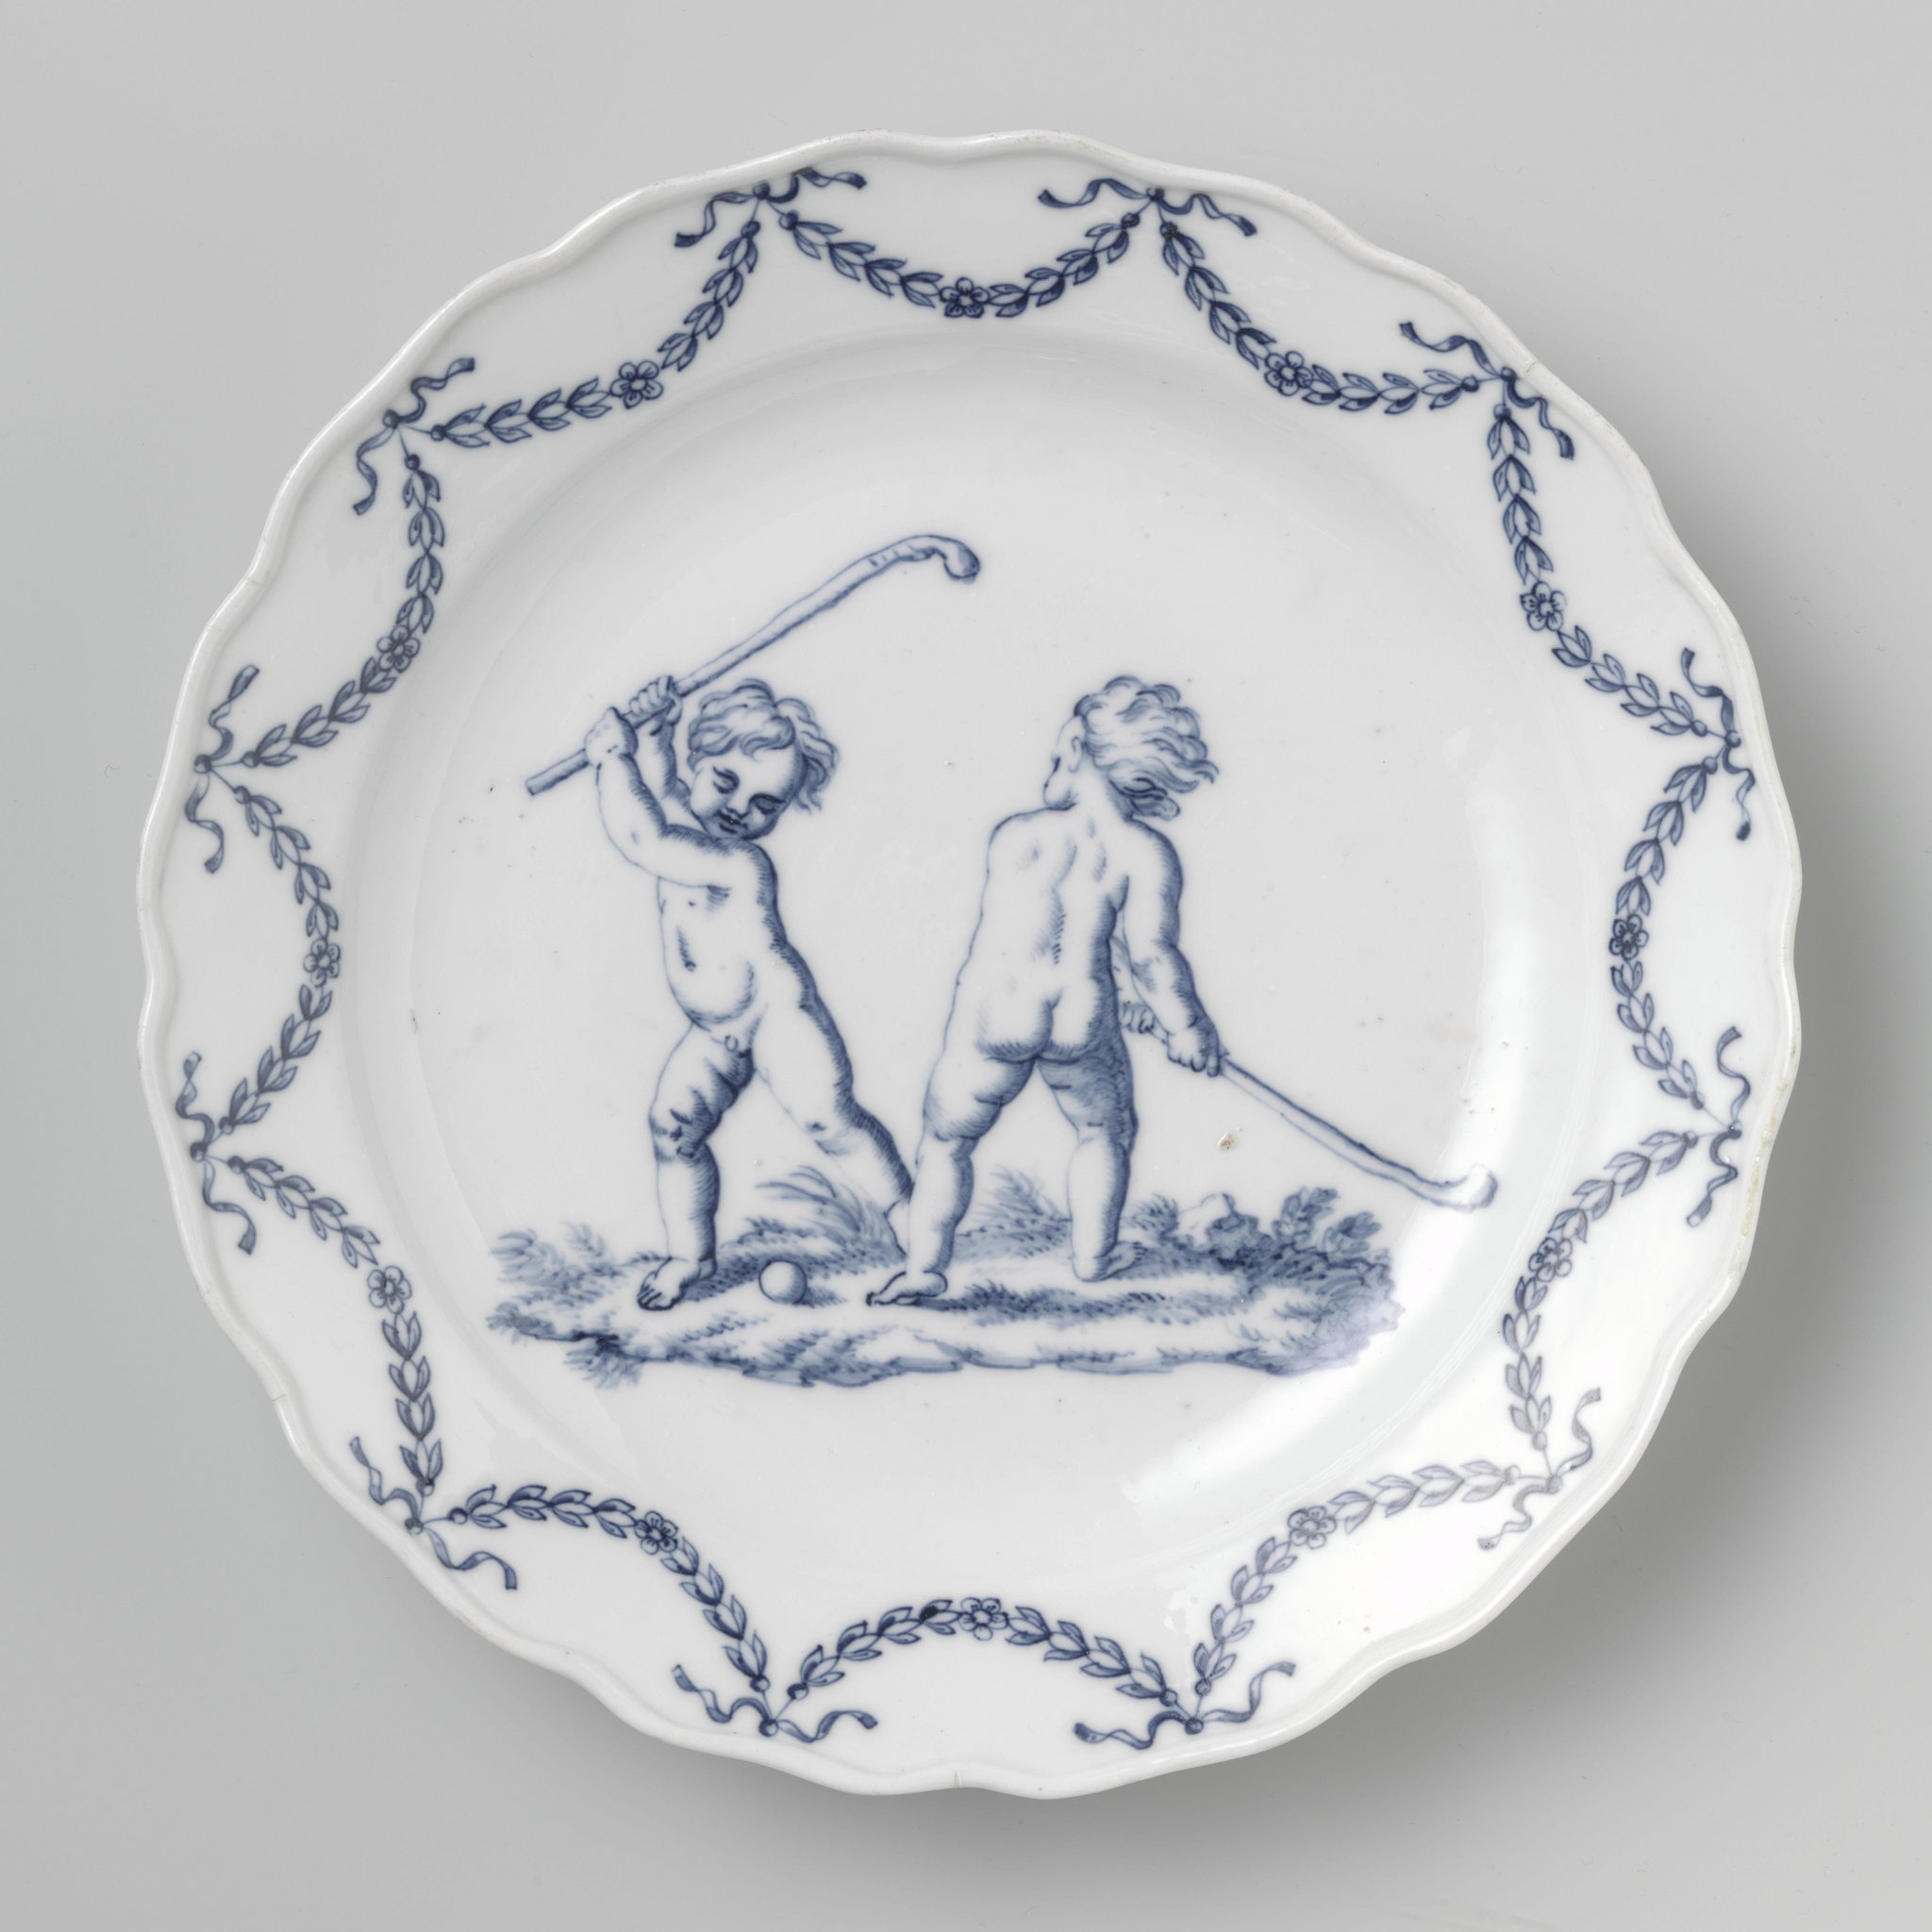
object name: platter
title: Schotel, beschilderd met twee kolfspelende kinderen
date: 1765-1770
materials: porcelain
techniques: painted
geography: meissen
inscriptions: factory mark, mark: ‘//’, mold mark: ‘56’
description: Ronde schotel van beschilderd porselein. De schotel heeft een geprofileerde en geschulpte rand en is beschilderd in onderglazuurblauw met op de spiegel twee kolfspelende kinderen op een grond, zgn. spielende Kinder à la Raphael en op de rand festoenen. De schotel is gemerkt.